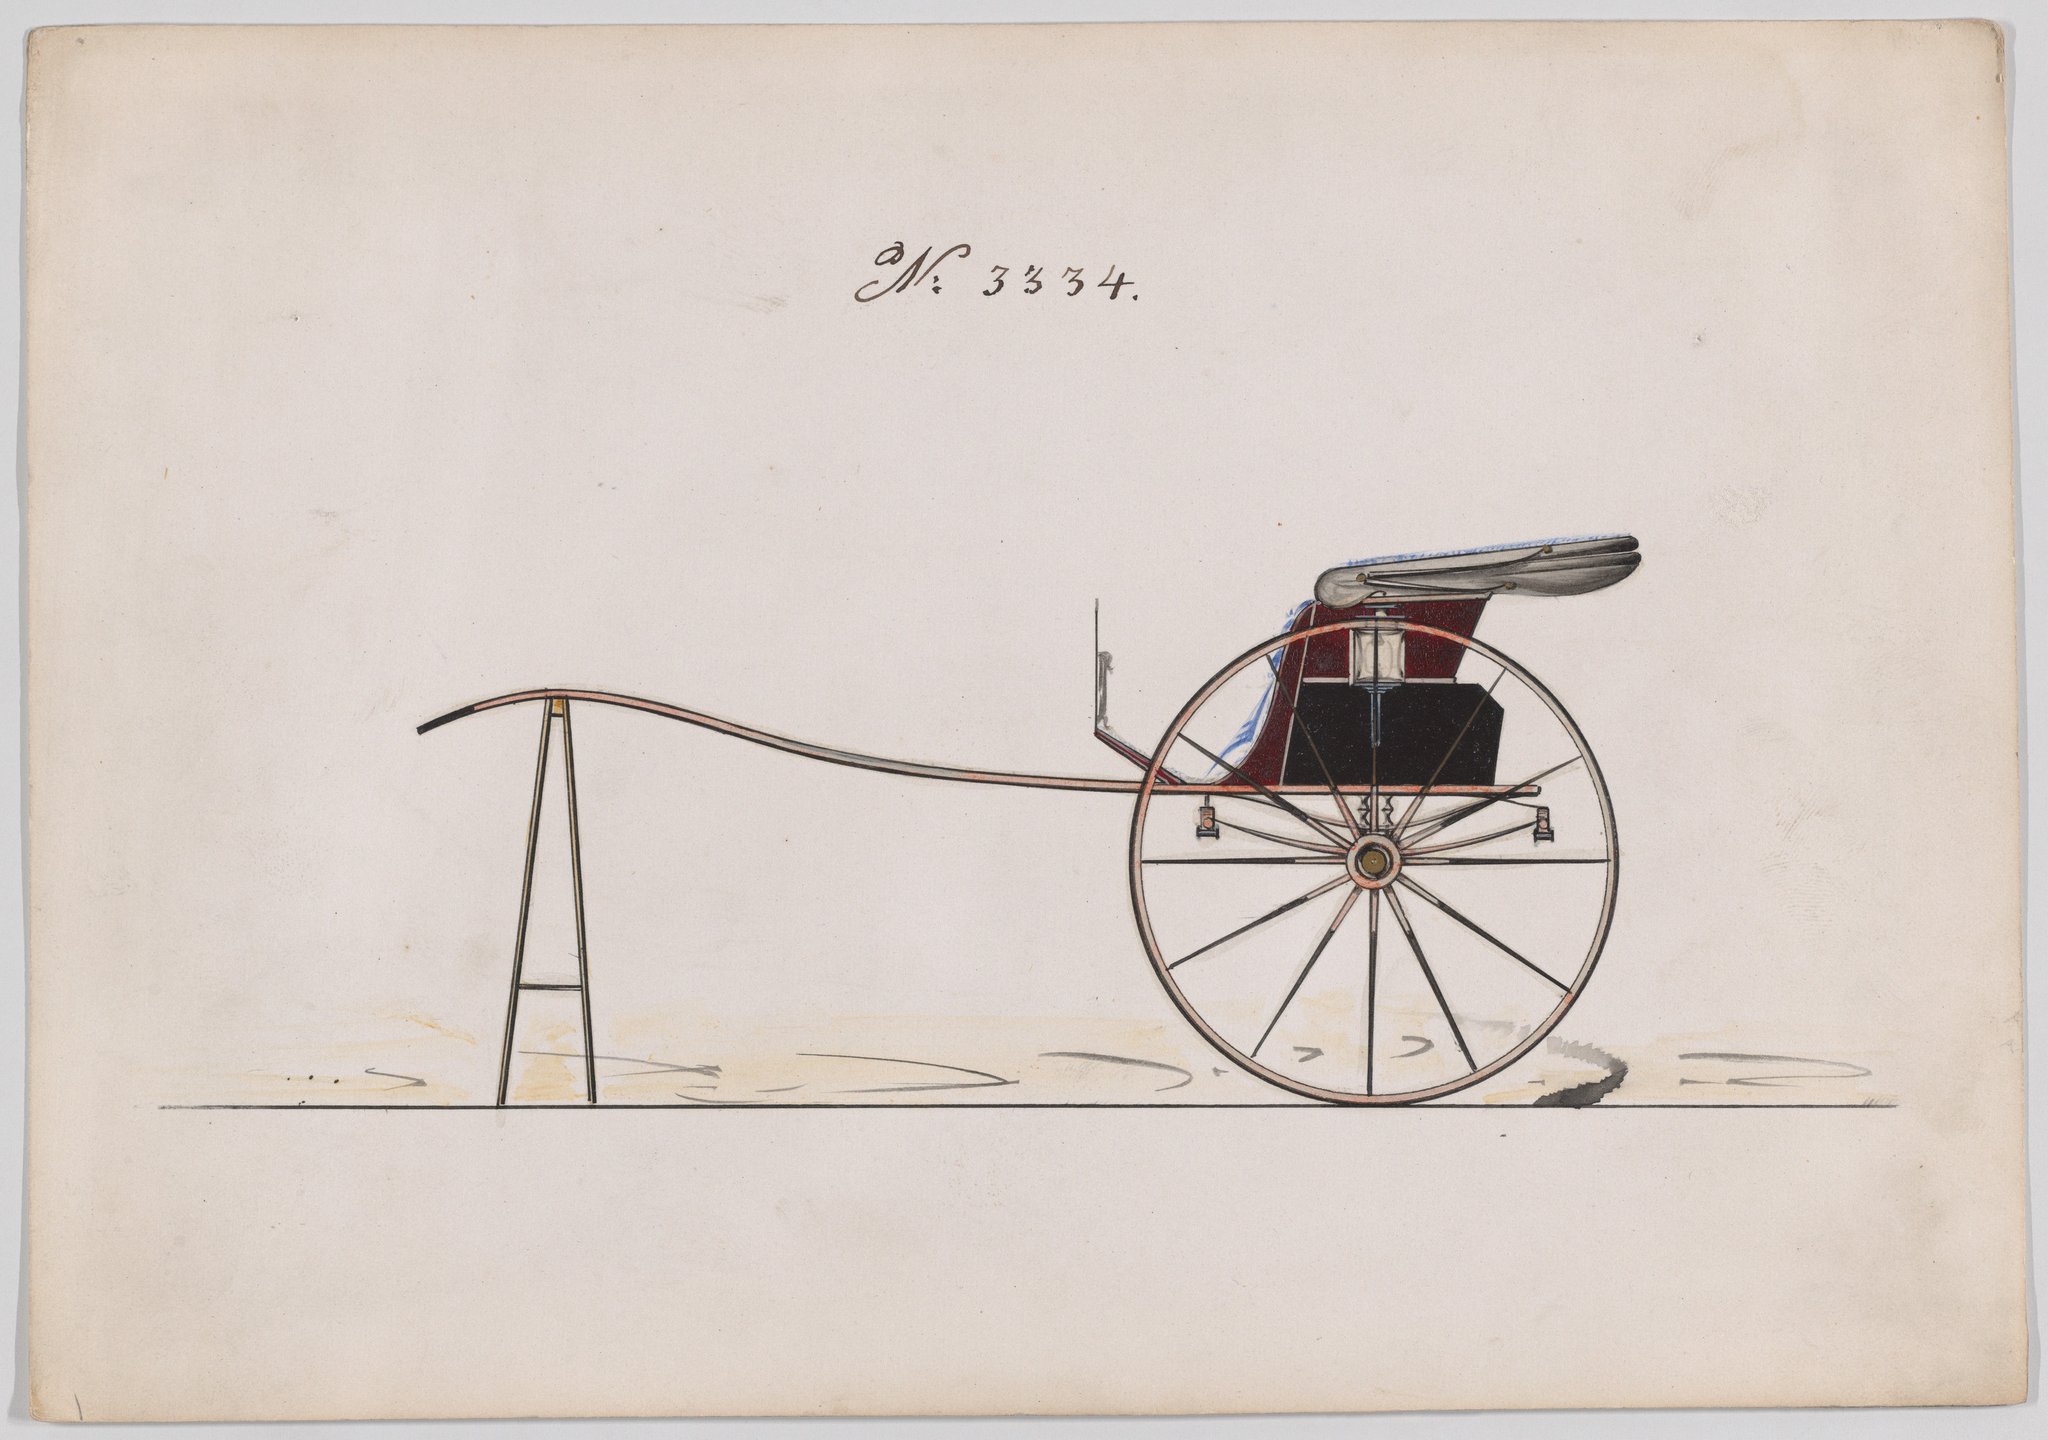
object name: drawing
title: Stanhope Gig # 3334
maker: brewster & co.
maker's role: manufacturer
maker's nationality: american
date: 1877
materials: gouache, gum arabic, ink, watercolor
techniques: pen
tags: carriages